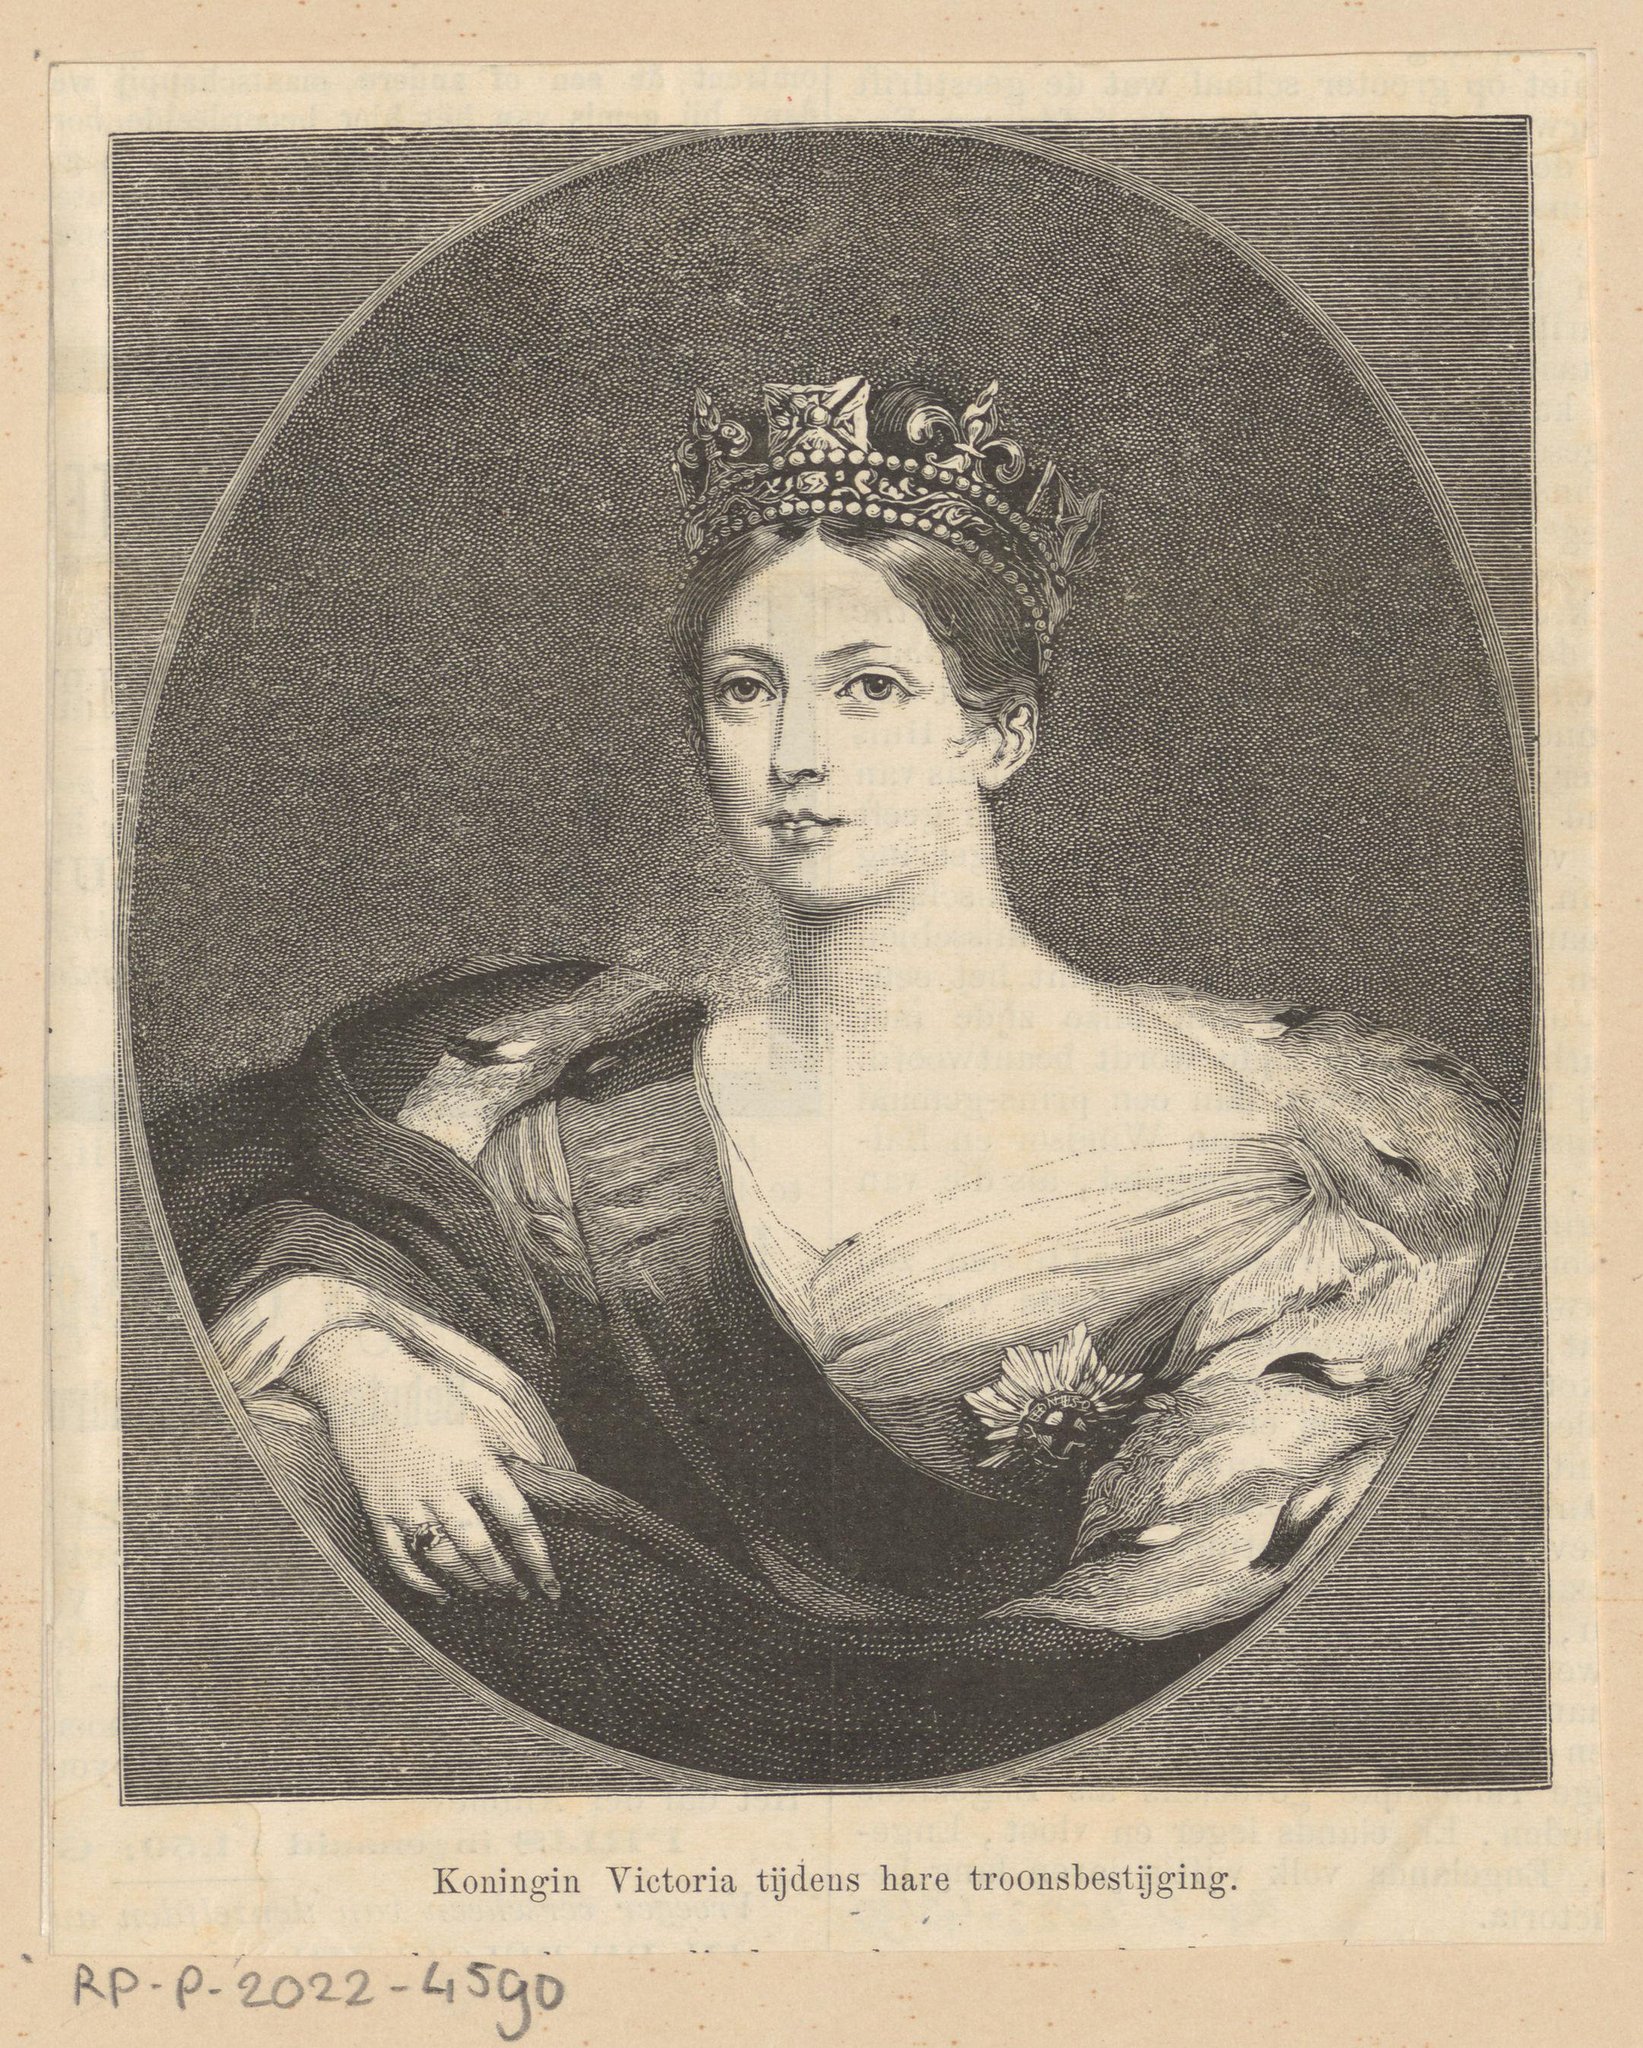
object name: print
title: Portret van koningin Victoria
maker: Anonymous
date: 1884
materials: paper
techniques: letterpress printing, engraving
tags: victoria (koningin van het verenigd koninkrijk en keizerin van india), historical persons - bb - woman, queen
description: Prent waarschijnlijk uit: De Financier (1884-02-06).